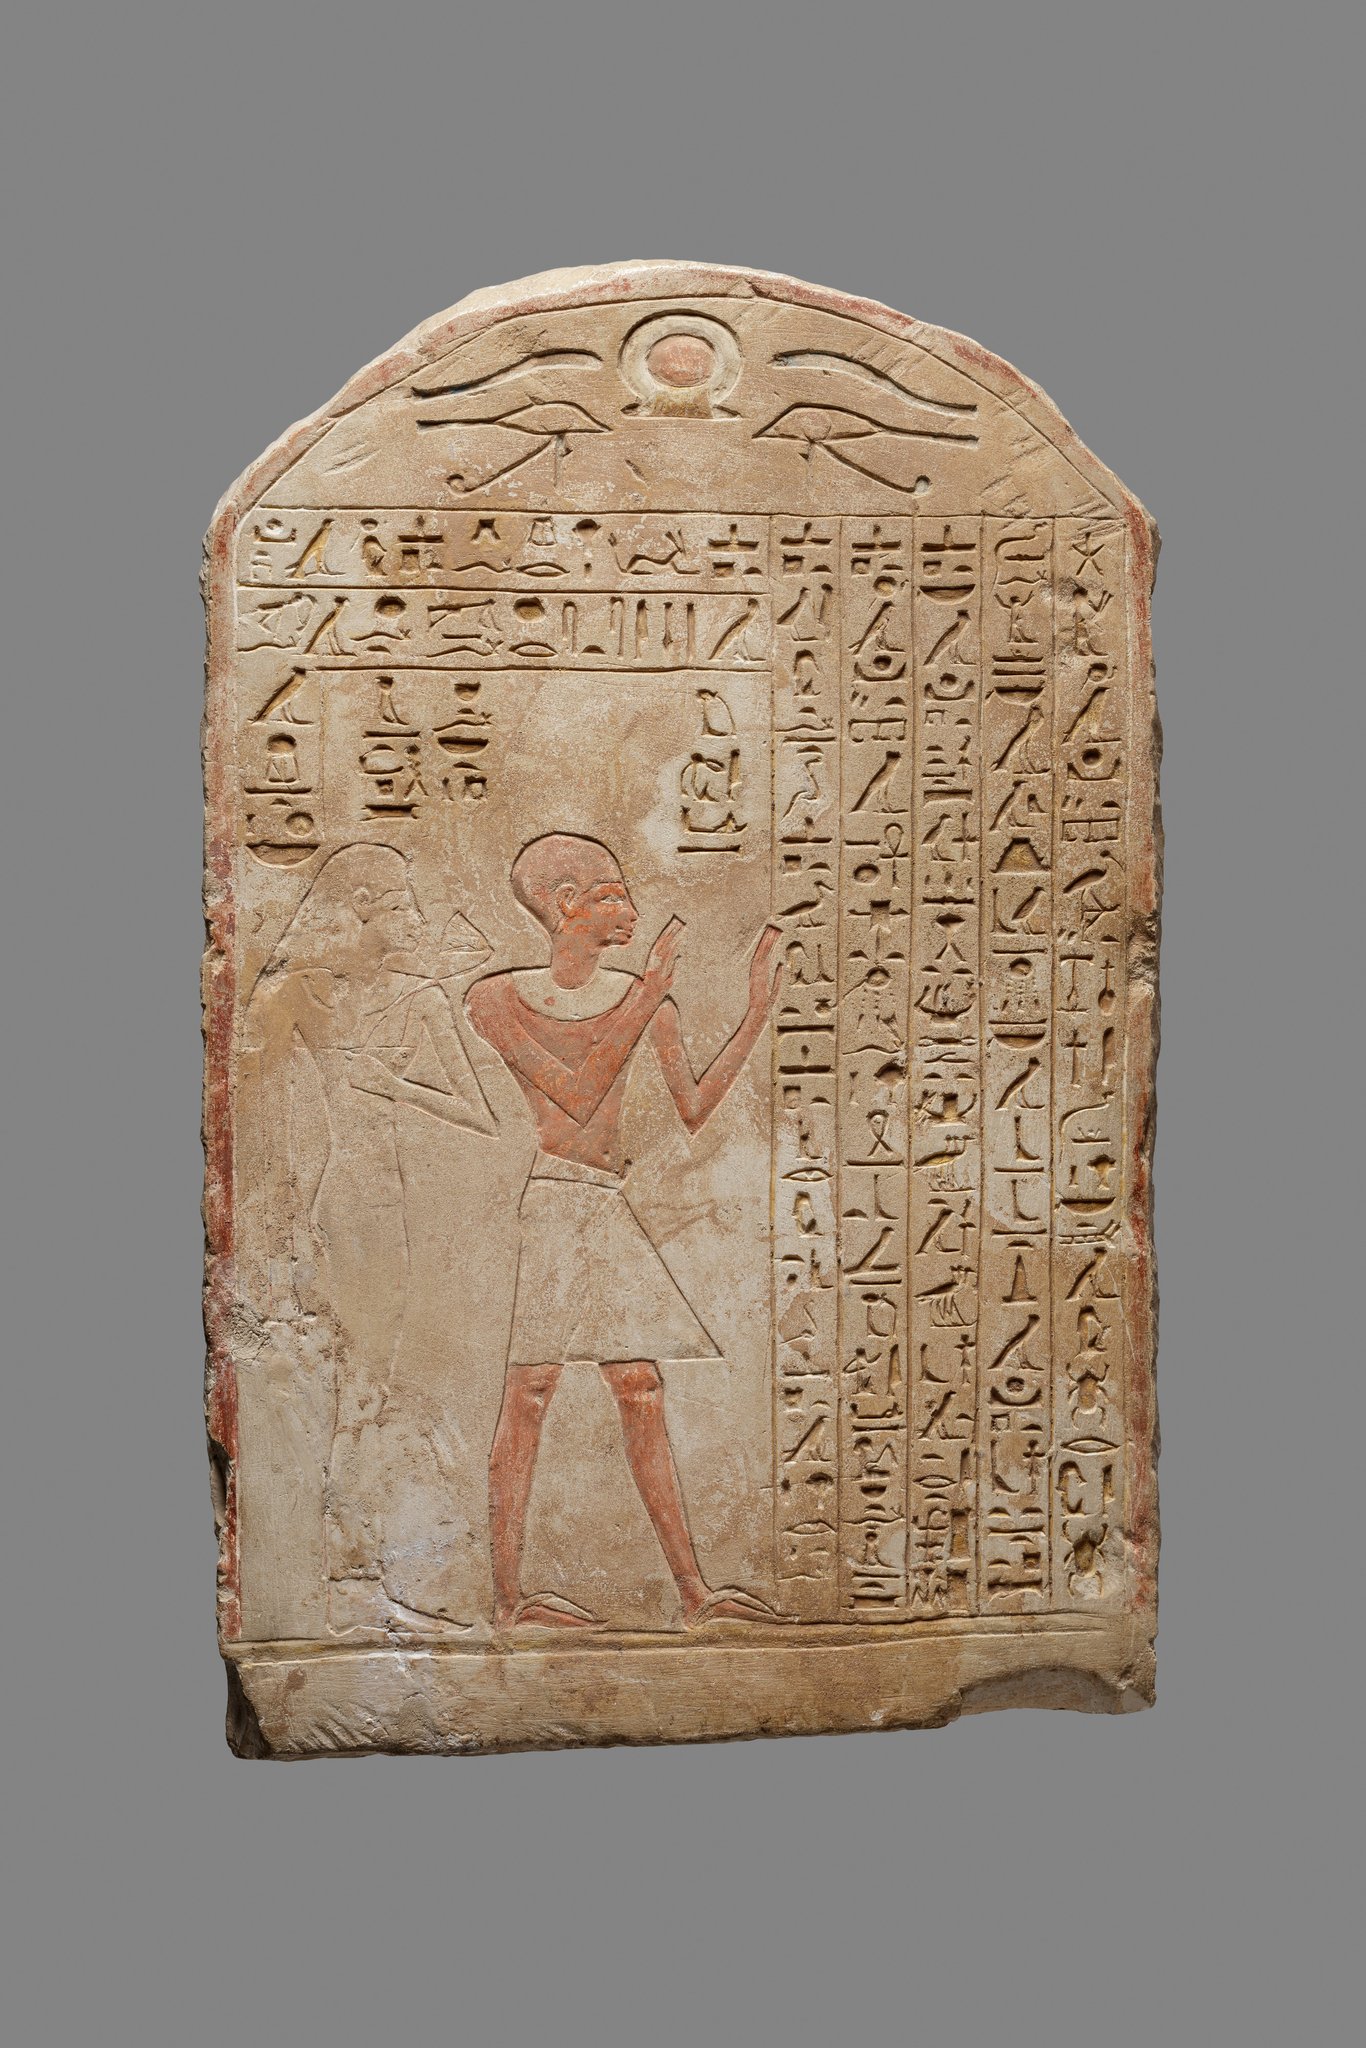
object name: stela, ameny, inethapy, inet hapy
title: Stela of Ameny and his Wife Inet-Hapy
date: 1504-1400 BCE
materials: limestone, paint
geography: egypt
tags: men,women,hieroglyphs